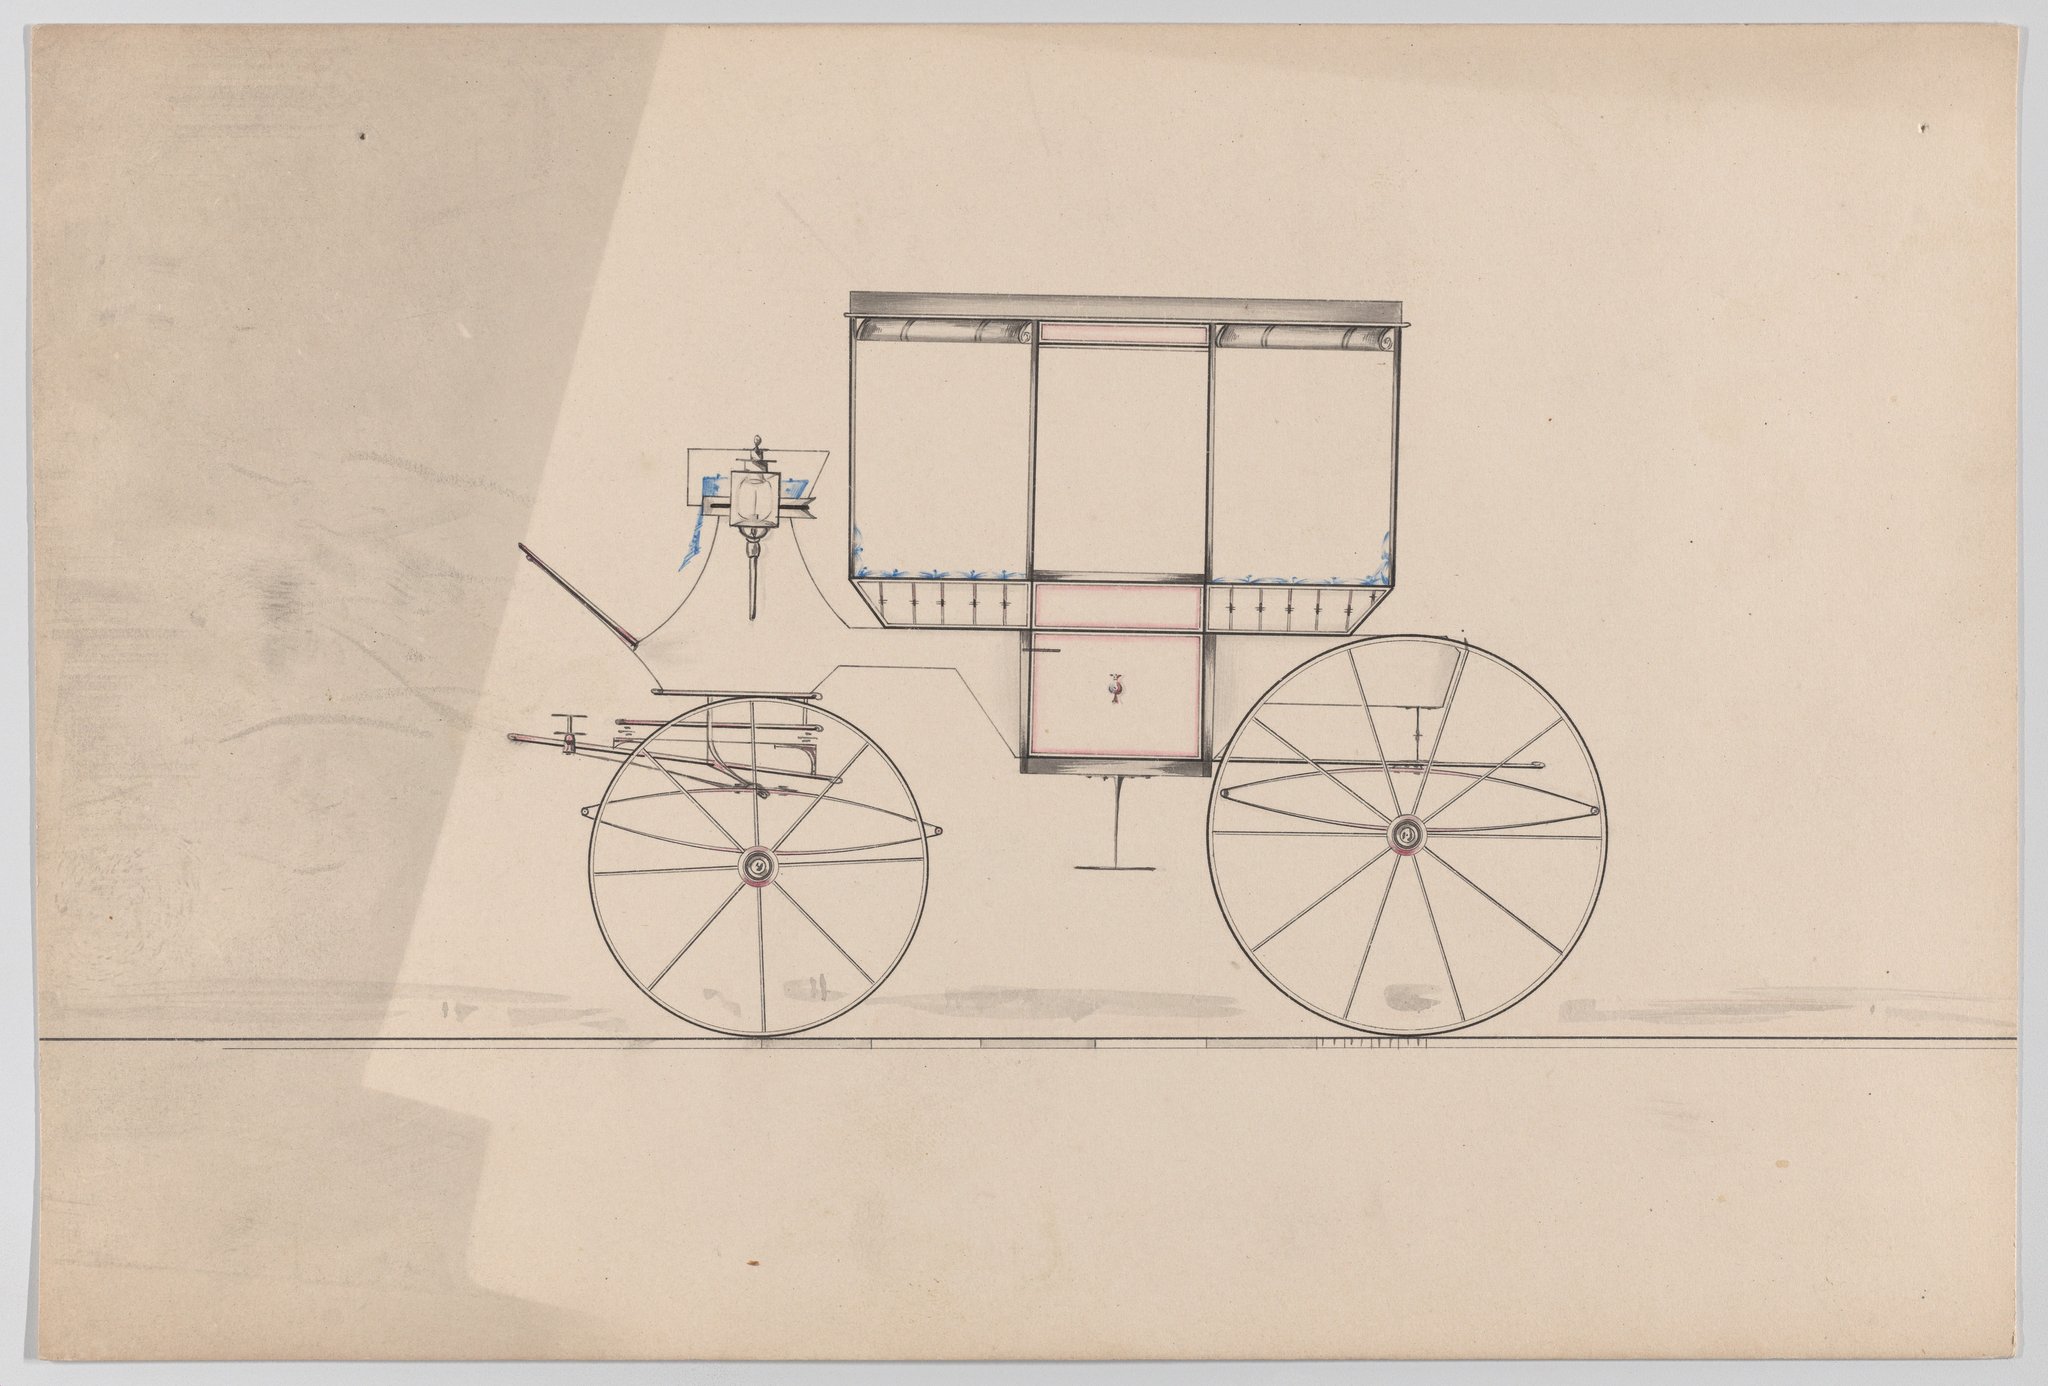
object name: drawing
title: Design for Curtain Coach (unnumbered)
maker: brewster & co.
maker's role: manufacturer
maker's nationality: american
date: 1850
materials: gouache, ink, watercolor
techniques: pen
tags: carriages